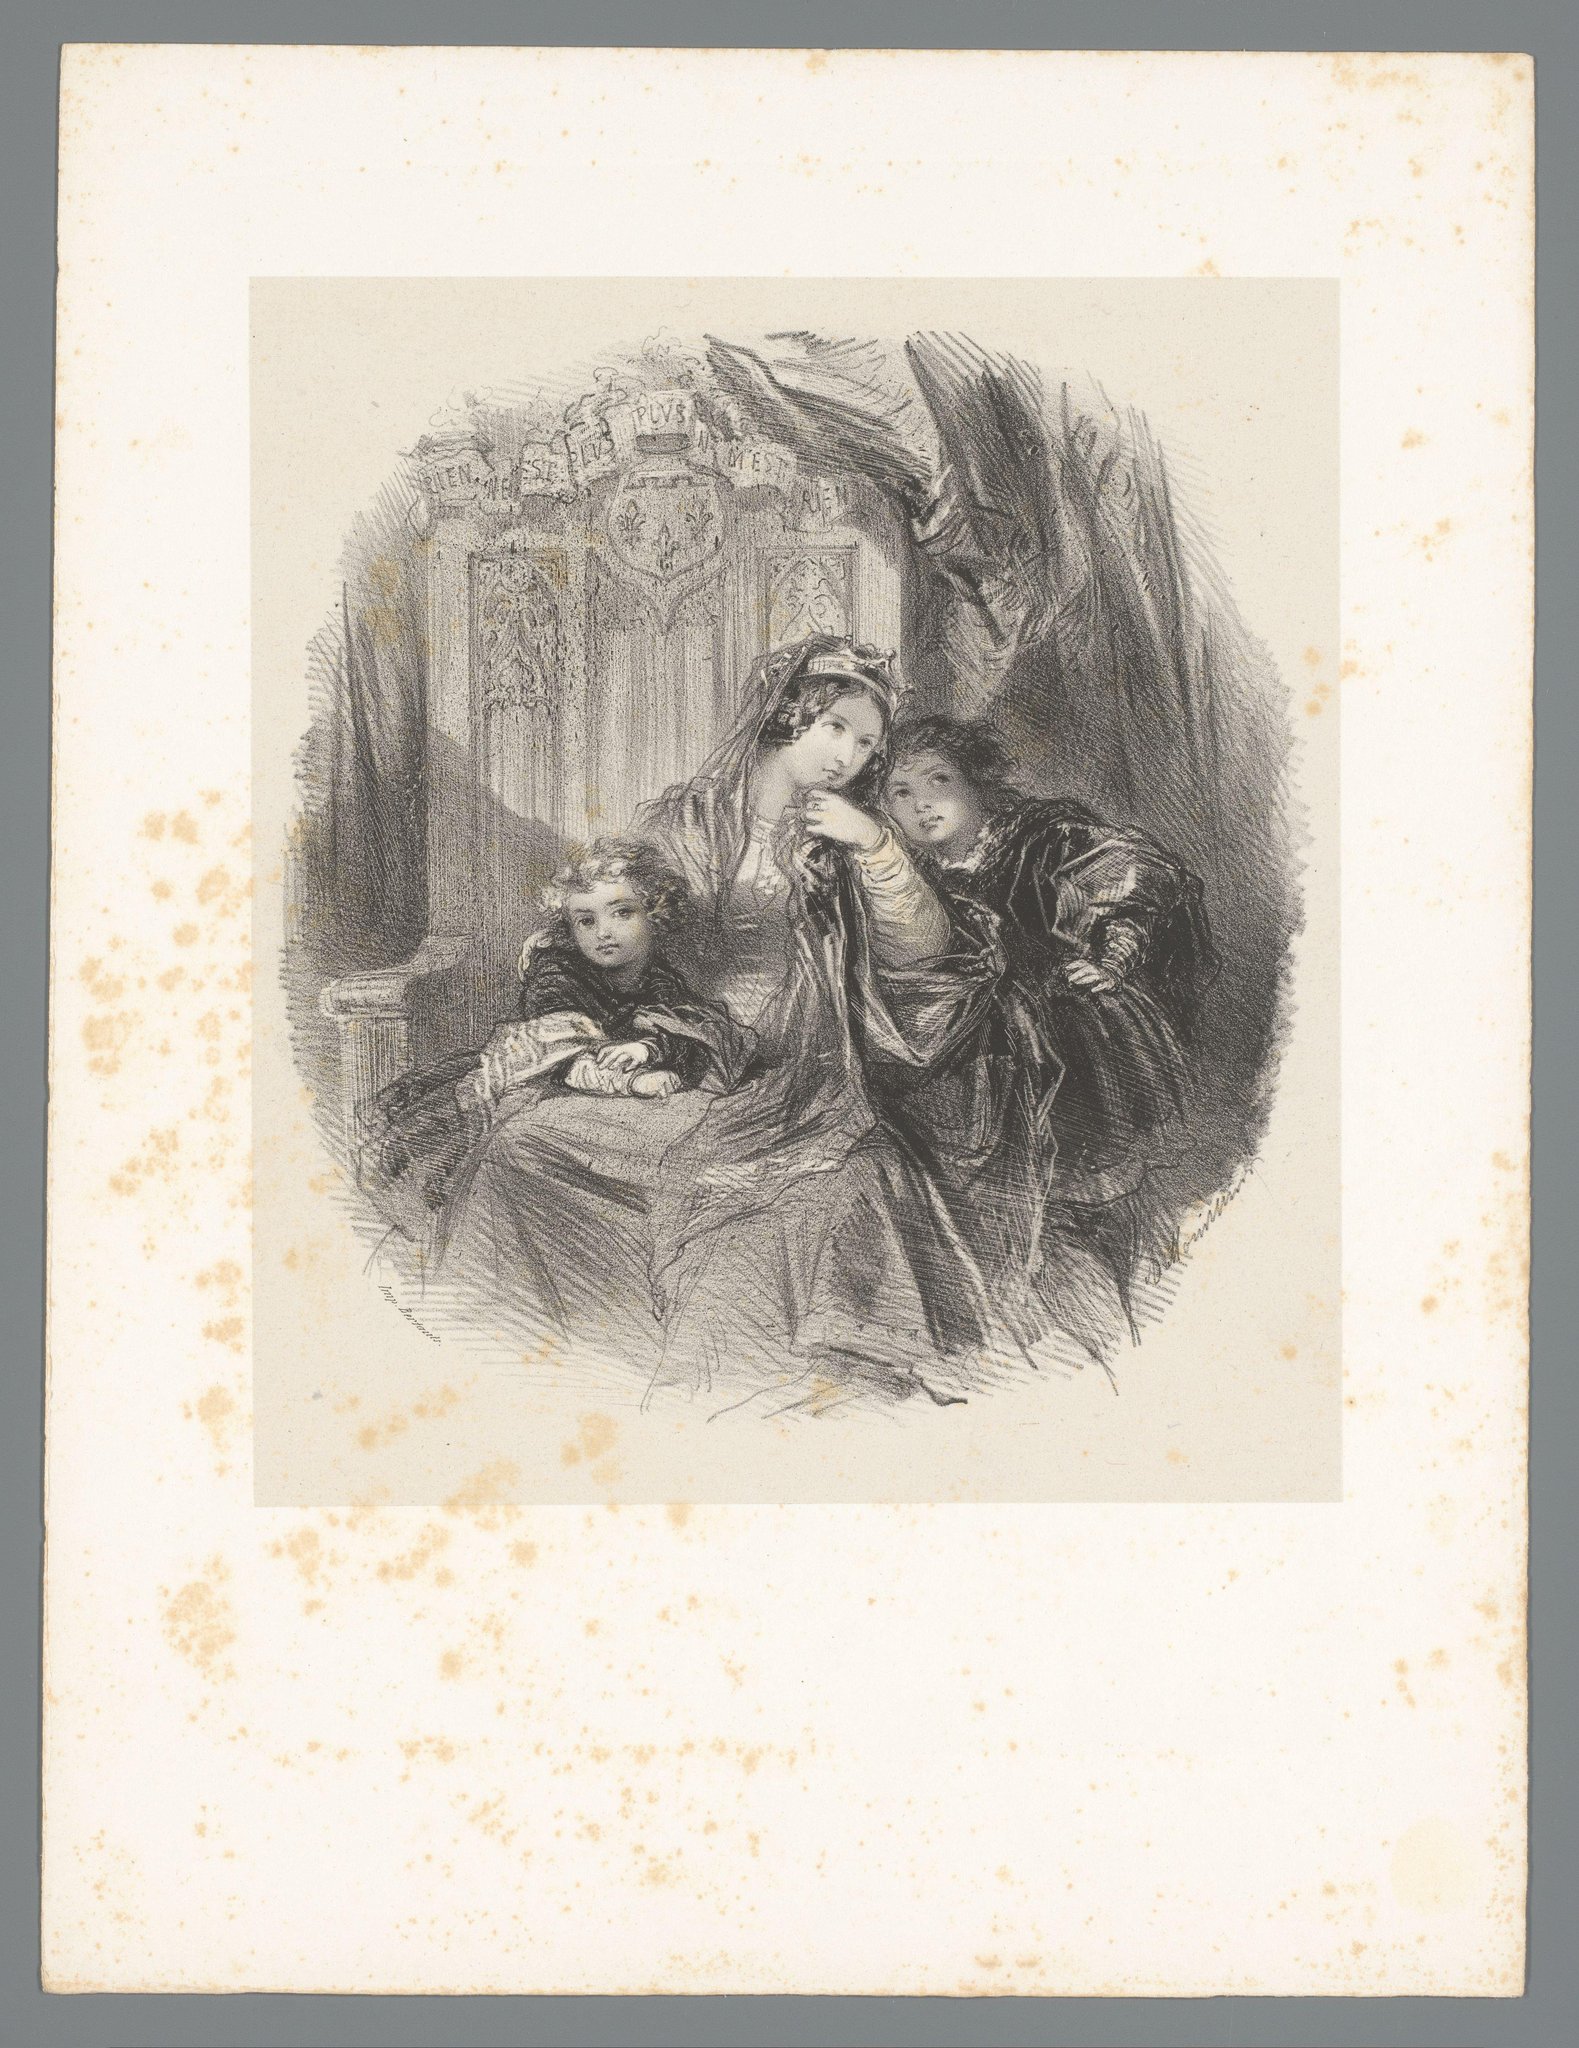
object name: print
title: Valentina Visconti op een troon met twee jonge kinderen aan haar zijde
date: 1830-1880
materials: paper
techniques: lithograph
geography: paris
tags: adult woman, child, throne, diadem, tiara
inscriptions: collector's mark: Lugt 964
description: Op de troon staat: Rien ne m'est plus, plus ne m'est rien. Valentina Visconti zou die woorden gebruikt hebben na de in haar ogen onrechtvaardige afhandeling van de moord in 1407 op haar echtgenoot, de Franse hertog Lodewijk van Orleans.